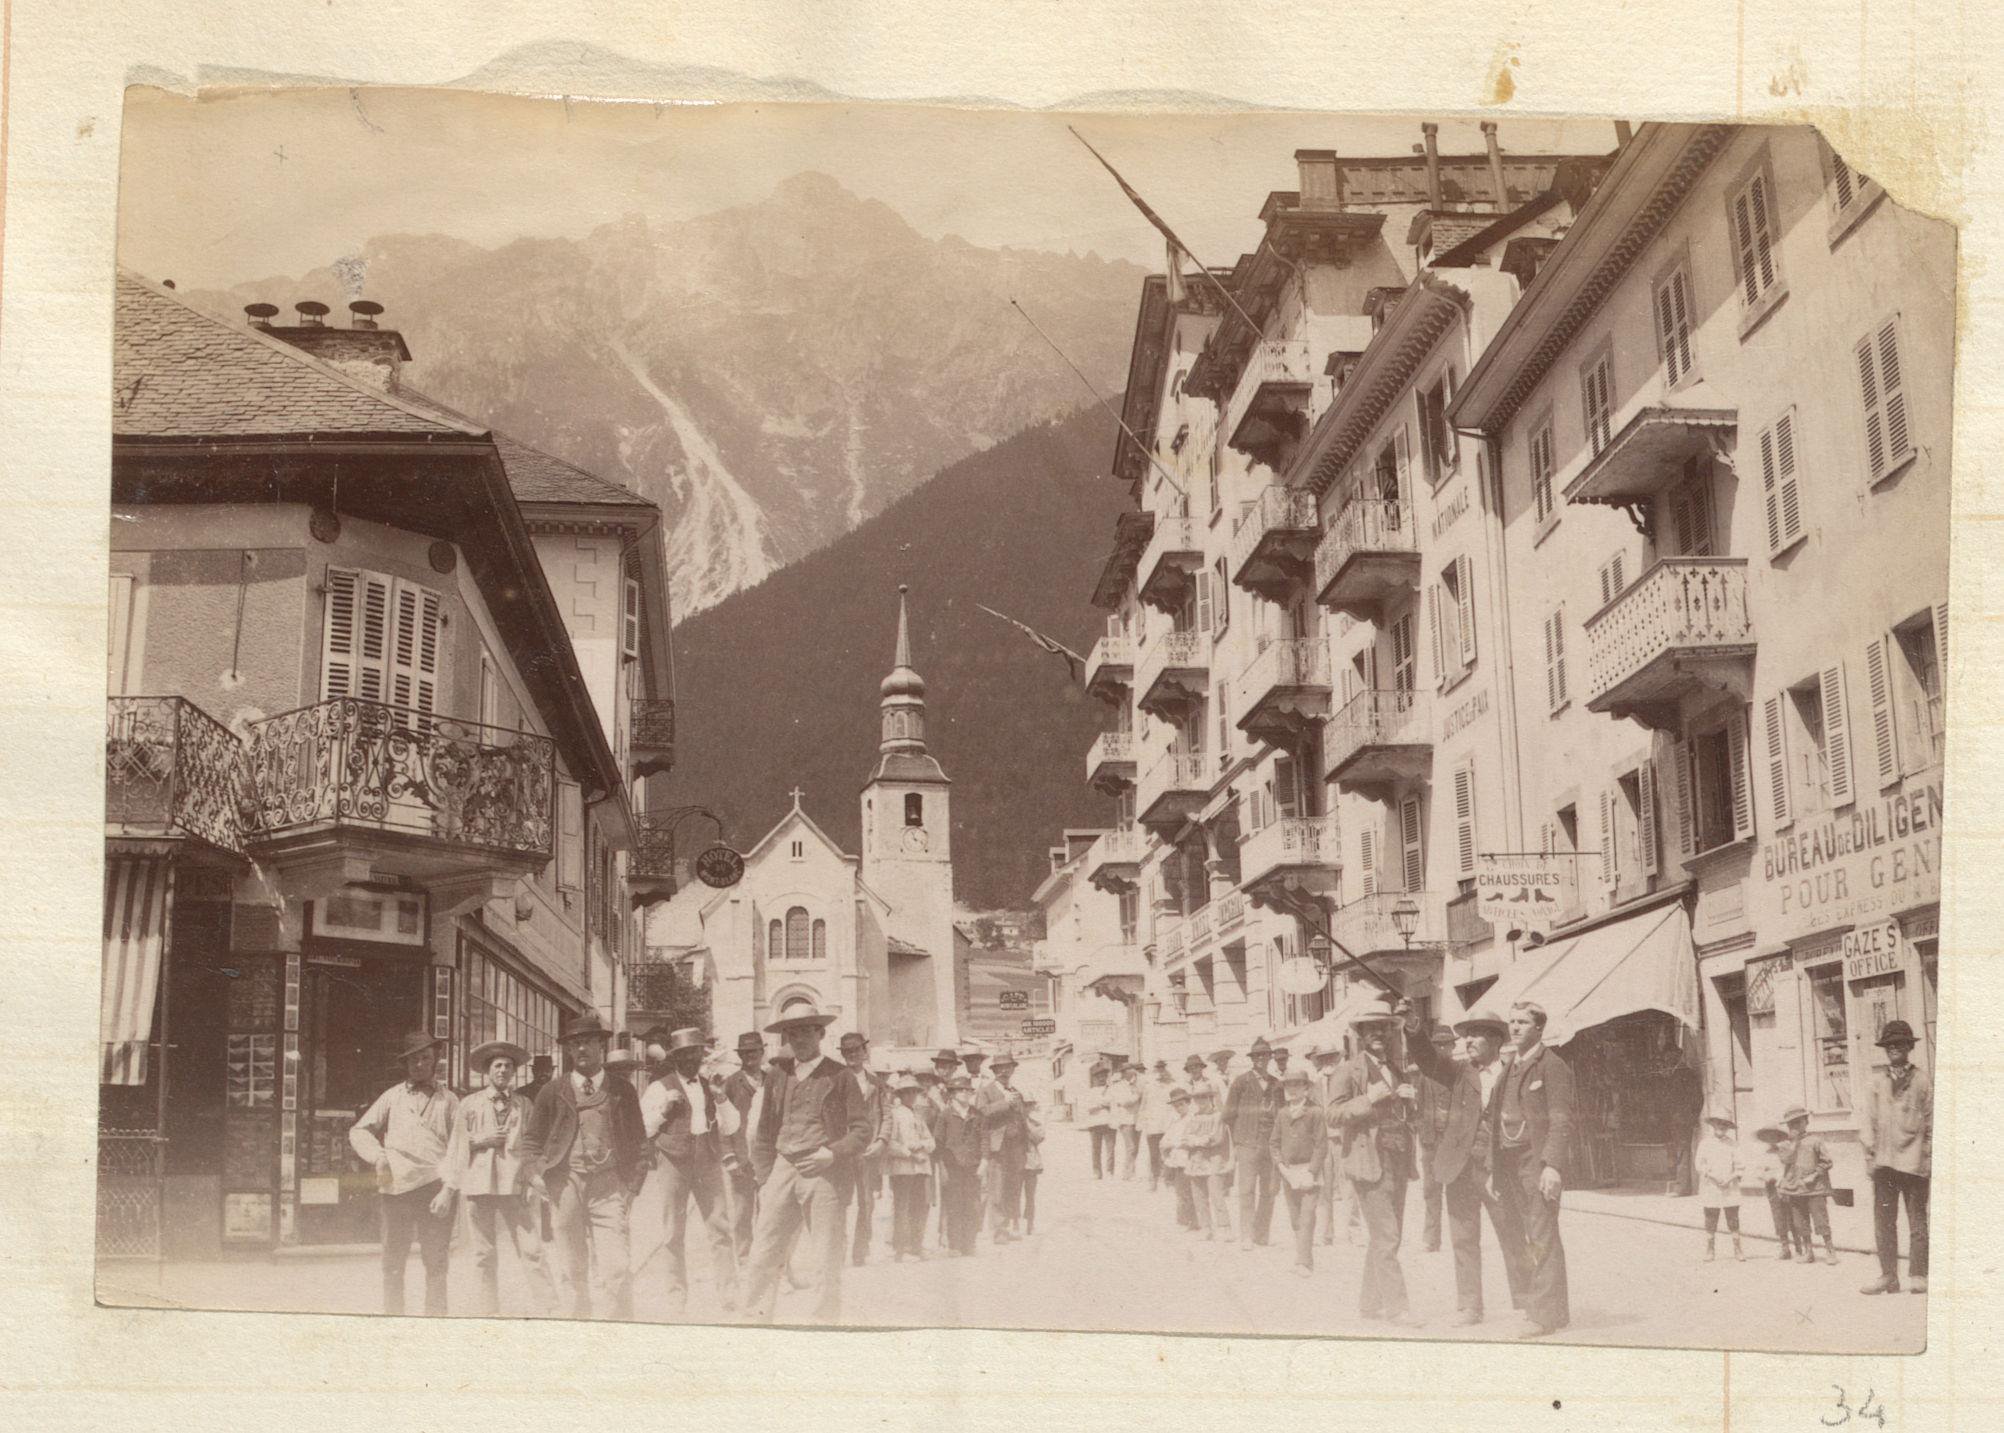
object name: photograph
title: Straatgezicht in een dorp, vermoedelijk in de Alpen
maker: Anonymous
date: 1880-1900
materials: paper, photographic support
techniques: albumen print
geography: alps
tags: street (+ city(-scape) with figures, staffage)